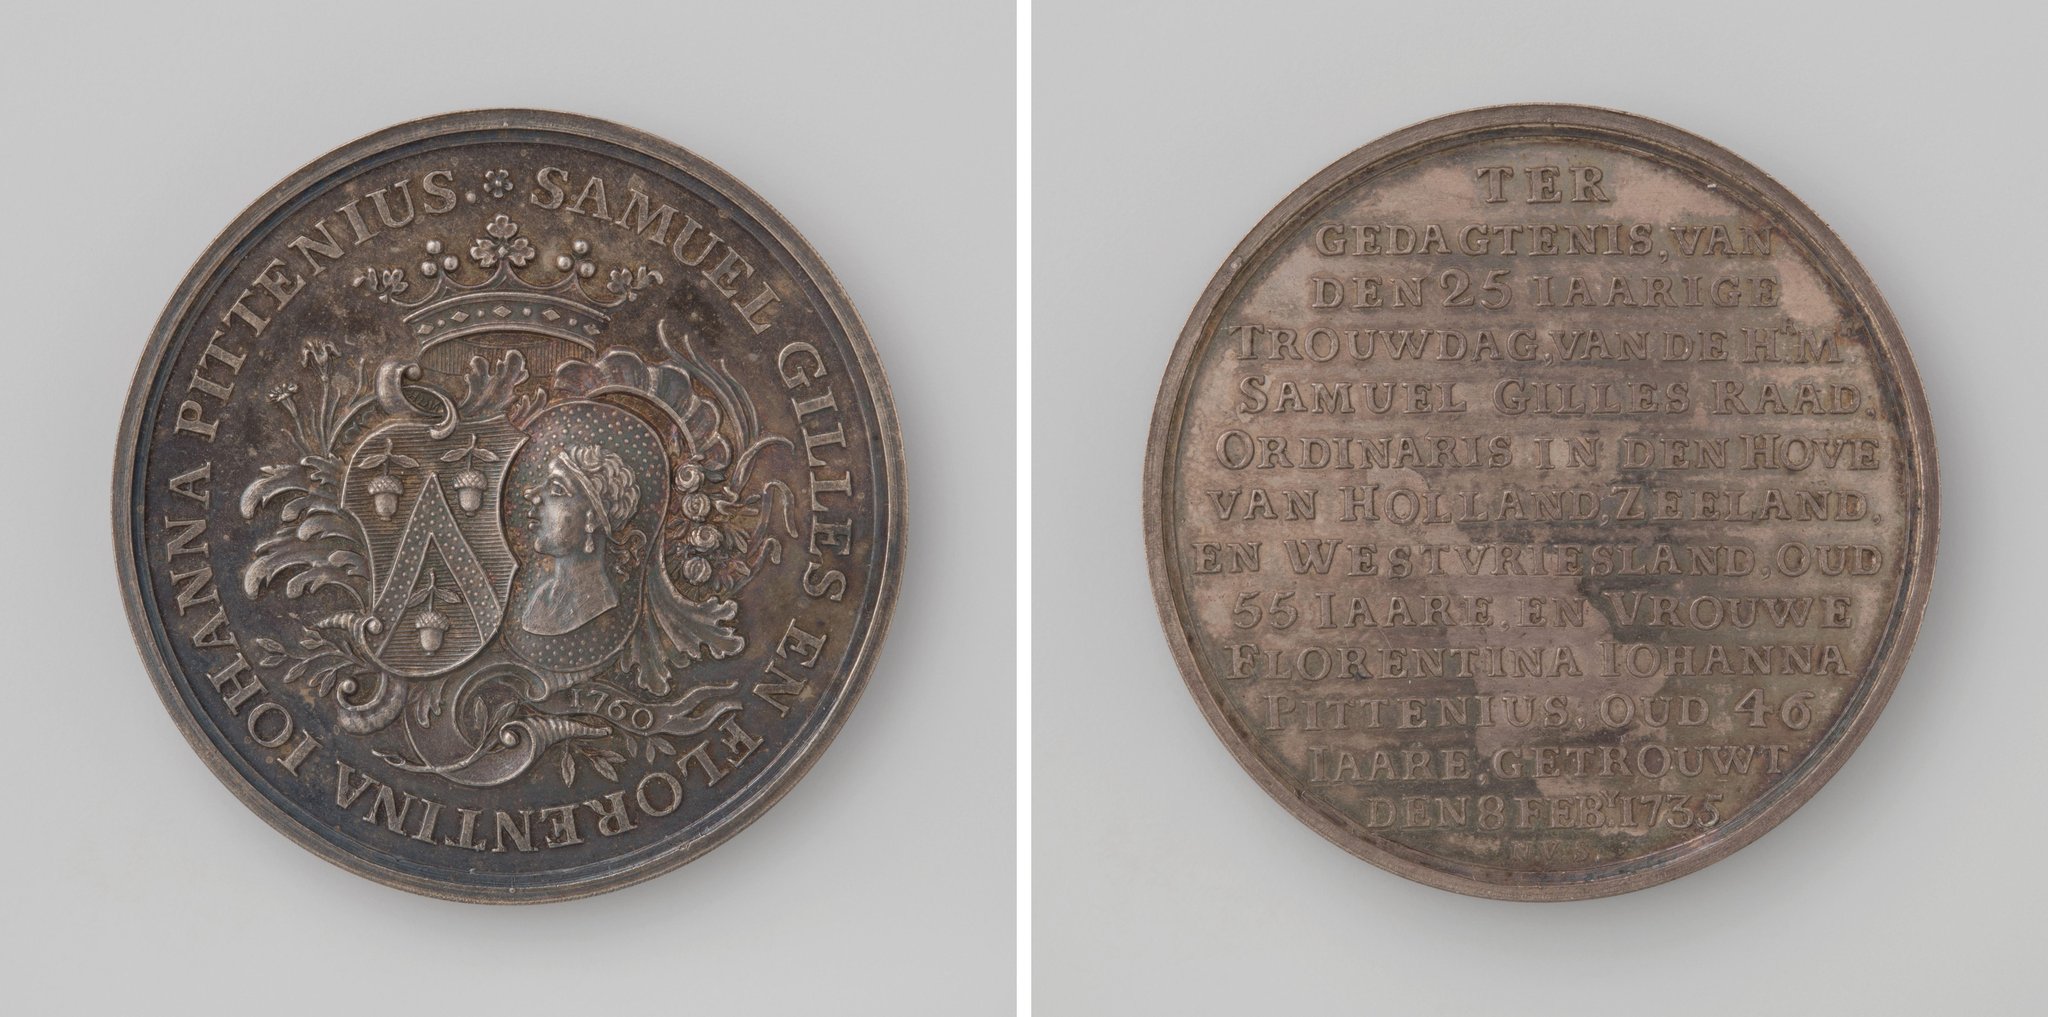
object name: marriage medal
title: Vijfentwintigjarig huwelijk van mr. Samuel Gilles, raad ordinaris in den Hove van Holland, Zeeland en West-Friesland en Florentina Johanna Pittenius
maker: nicolaas van swinderen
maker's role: jeweler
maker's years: 1705-1760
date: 1760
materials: silver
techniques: striking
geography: amsterdam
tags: hof van west-friesland, hof van zeeland, hof van holland, bestuurder, samuel gilles, florentina johanna pittenius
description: Zilveren penning. Voorzijde: twee wapenschilden temidden van bladertakken onder een kroon binnen omschrift. Keerzijde: opschrift